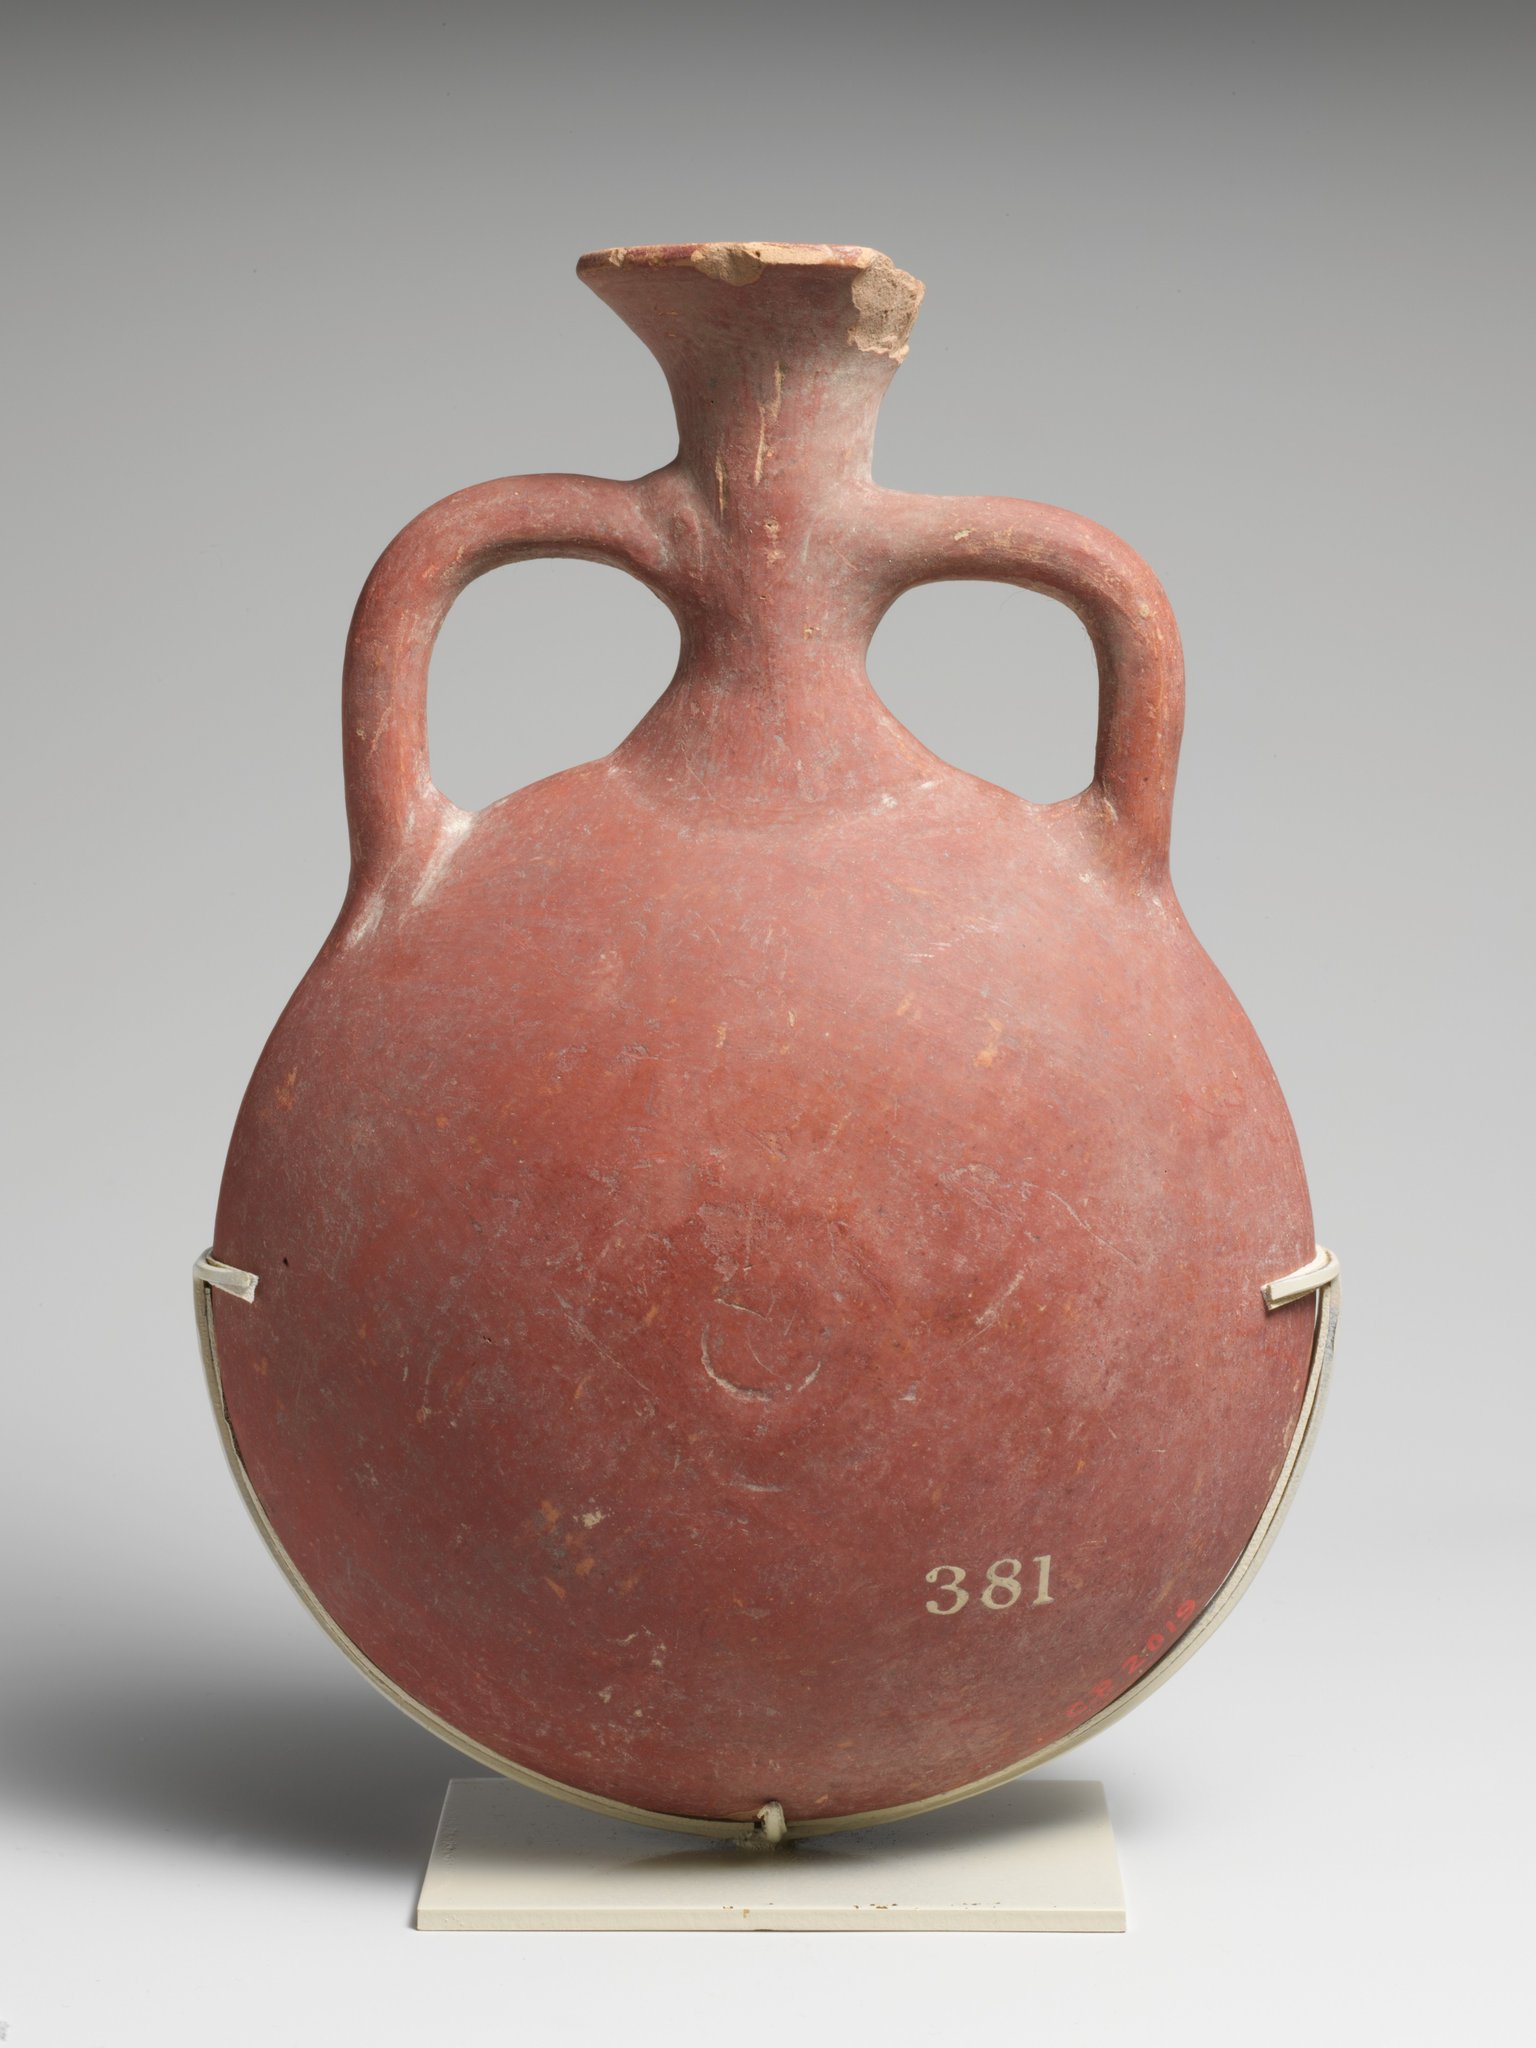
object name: flask, lentoid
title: Terracotta lentoid flask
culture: cypriot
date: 1600-1050 BCE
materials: terracotta